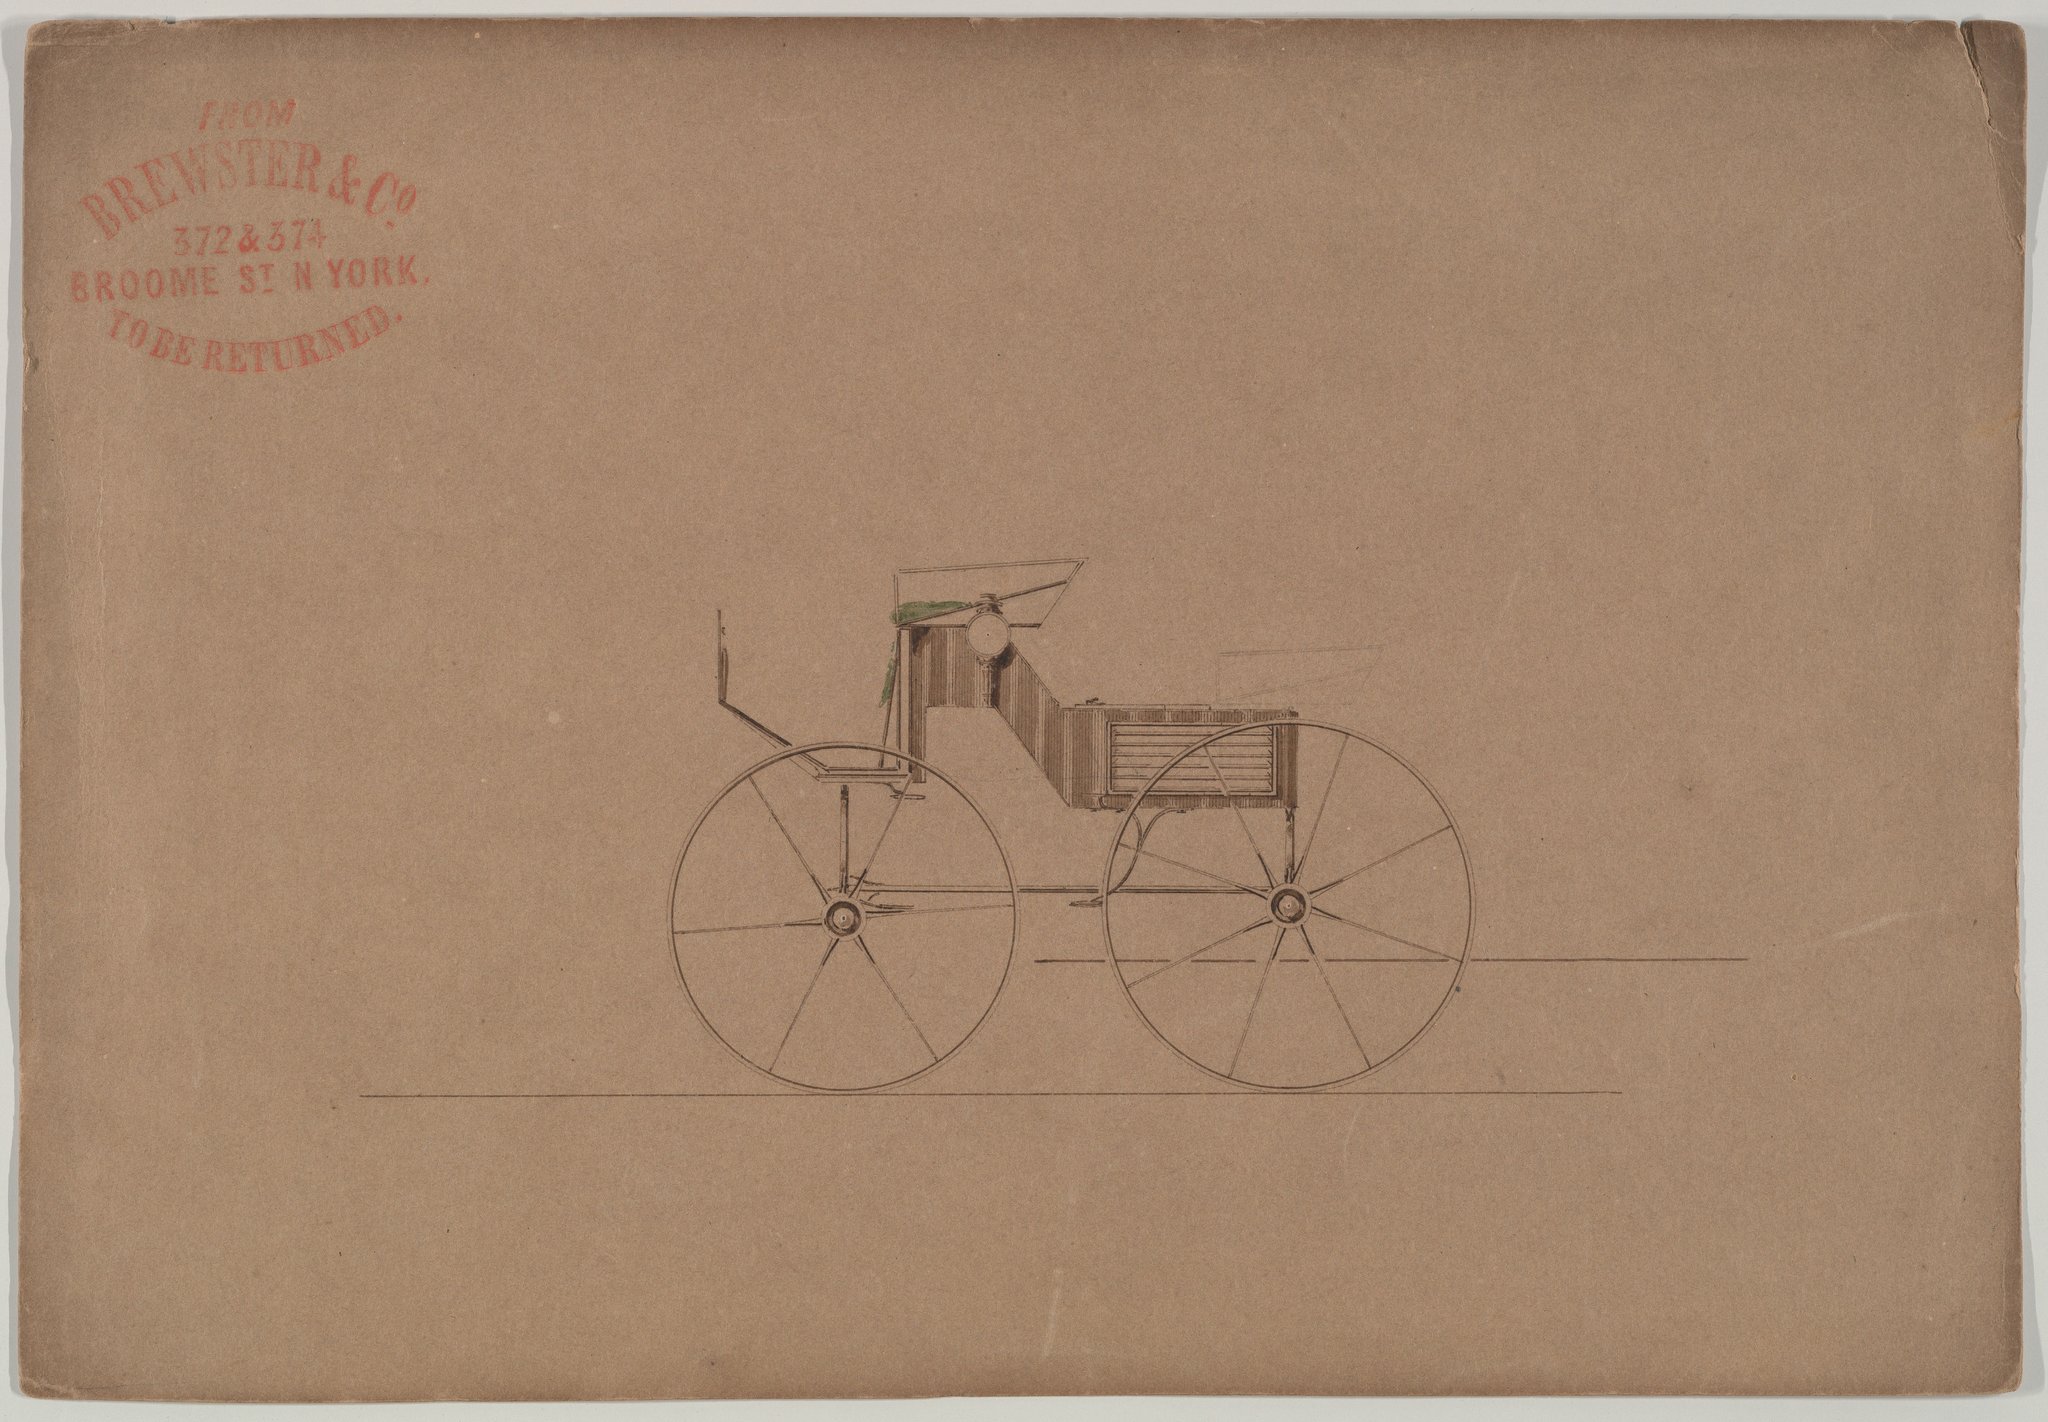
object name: drawing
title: Phaeton, no top (unnumbered)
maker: brewster & co.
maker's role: manufacturer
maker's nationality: american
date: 1850-1870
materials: ink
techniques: pen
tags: carriages